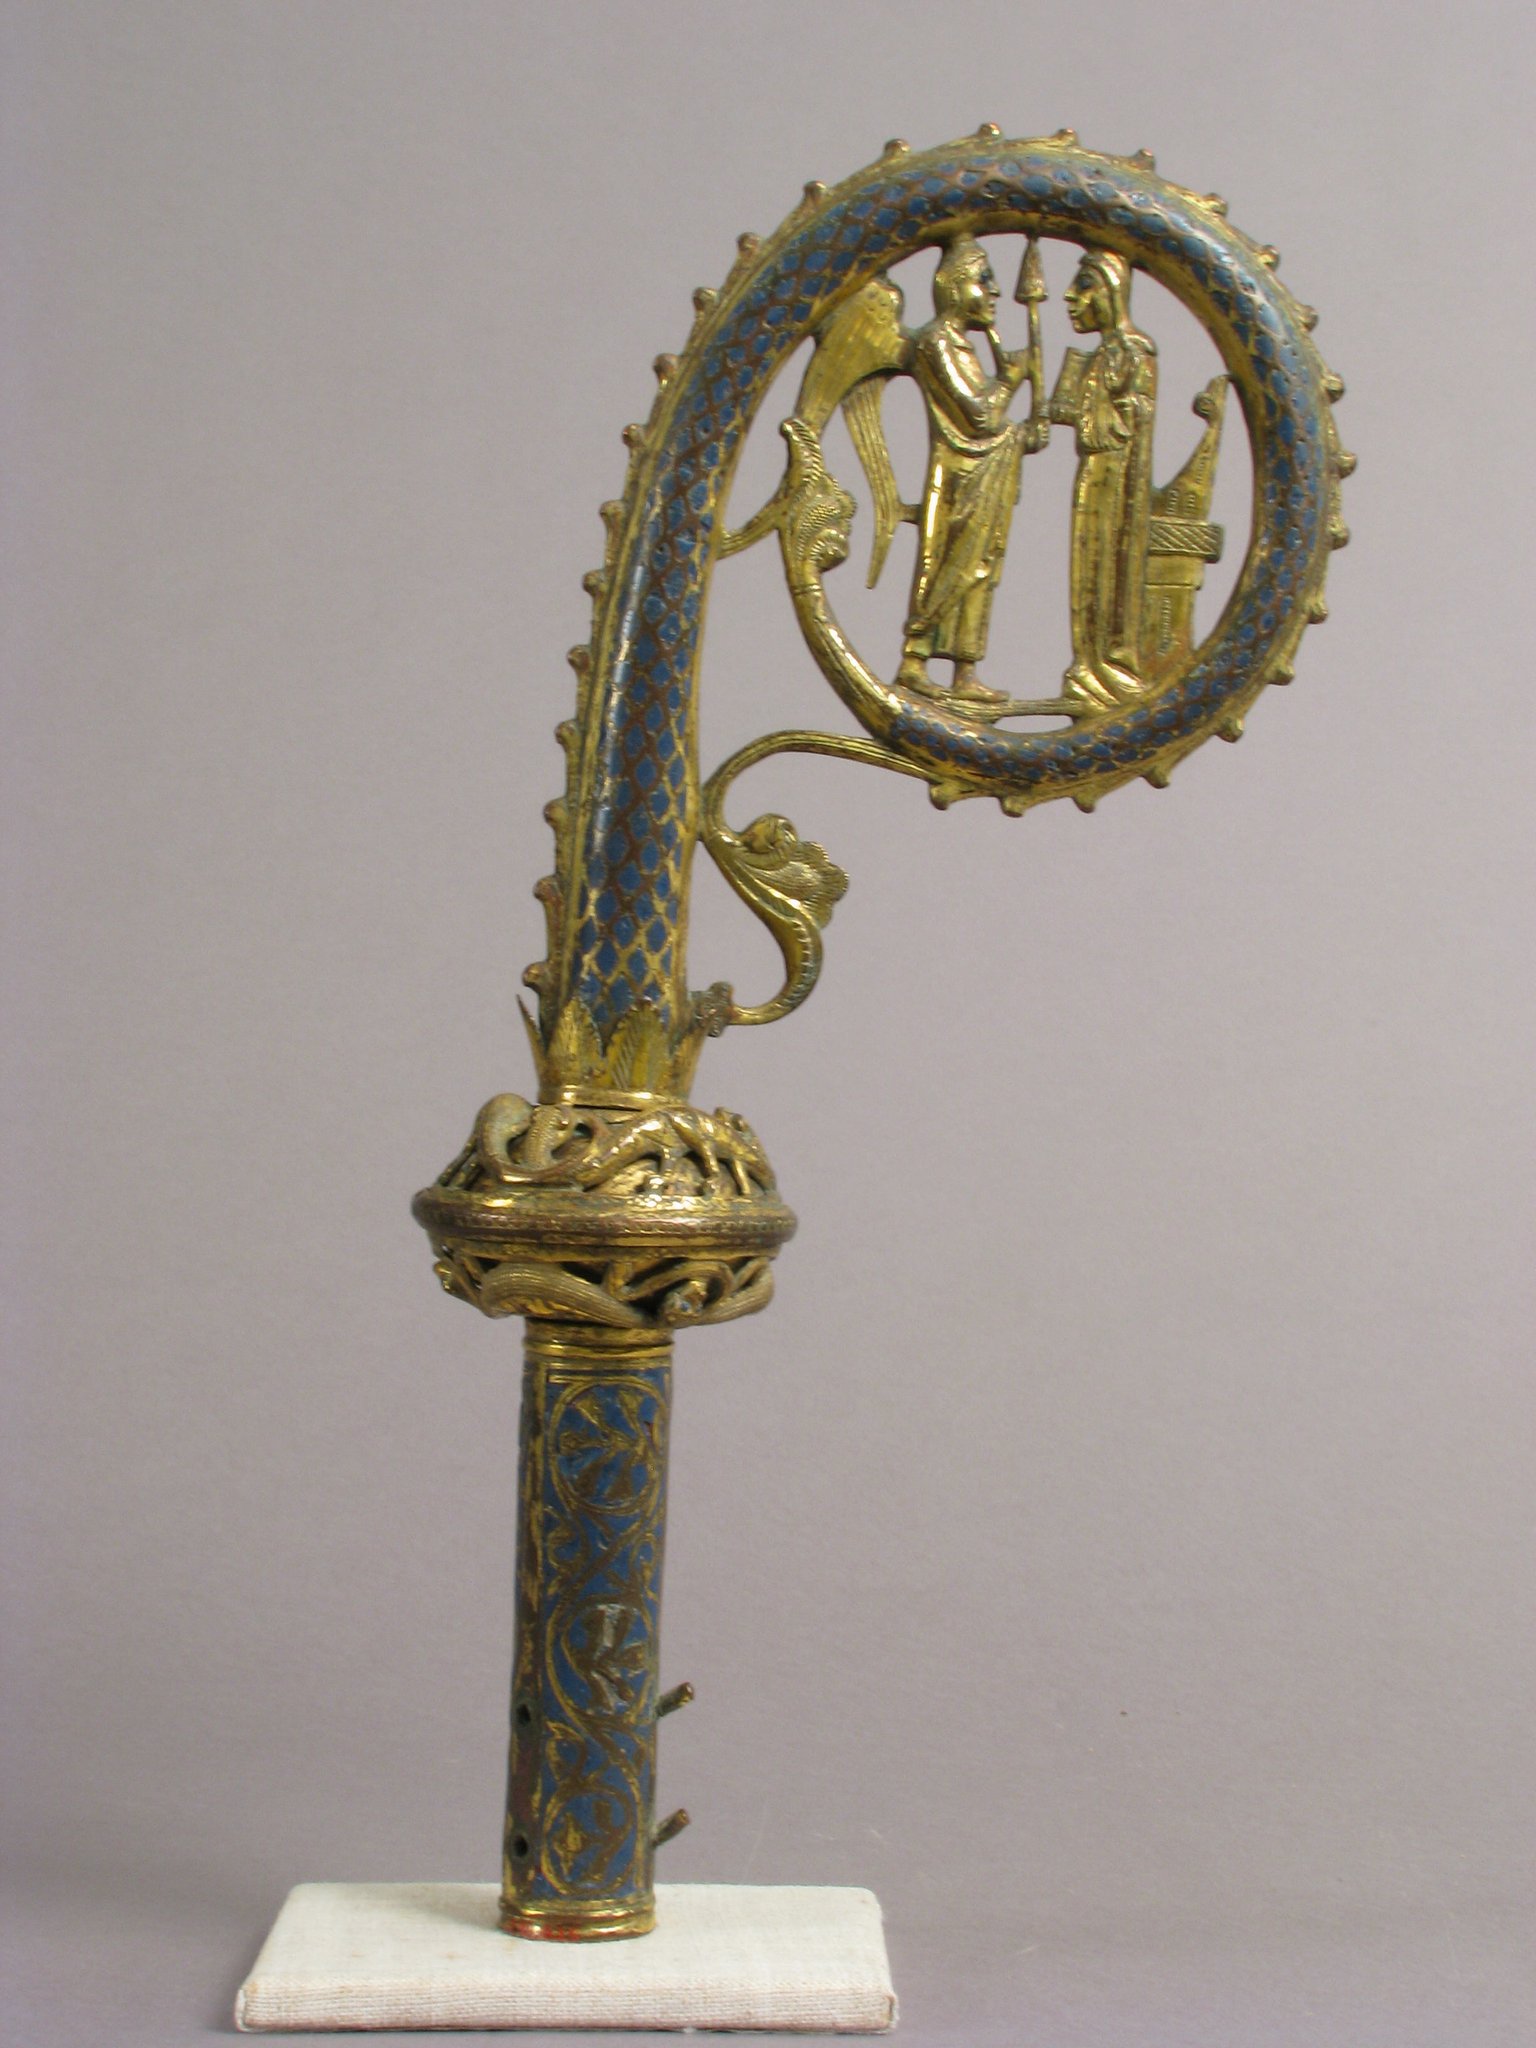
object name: crozier head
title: Head of a Crozier with the Annunciation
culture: french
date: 1225-1250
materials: copper, enamel, gilt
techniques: enamel, chasing, engraving, forming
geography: france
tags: angels,virgin mary,annunciation